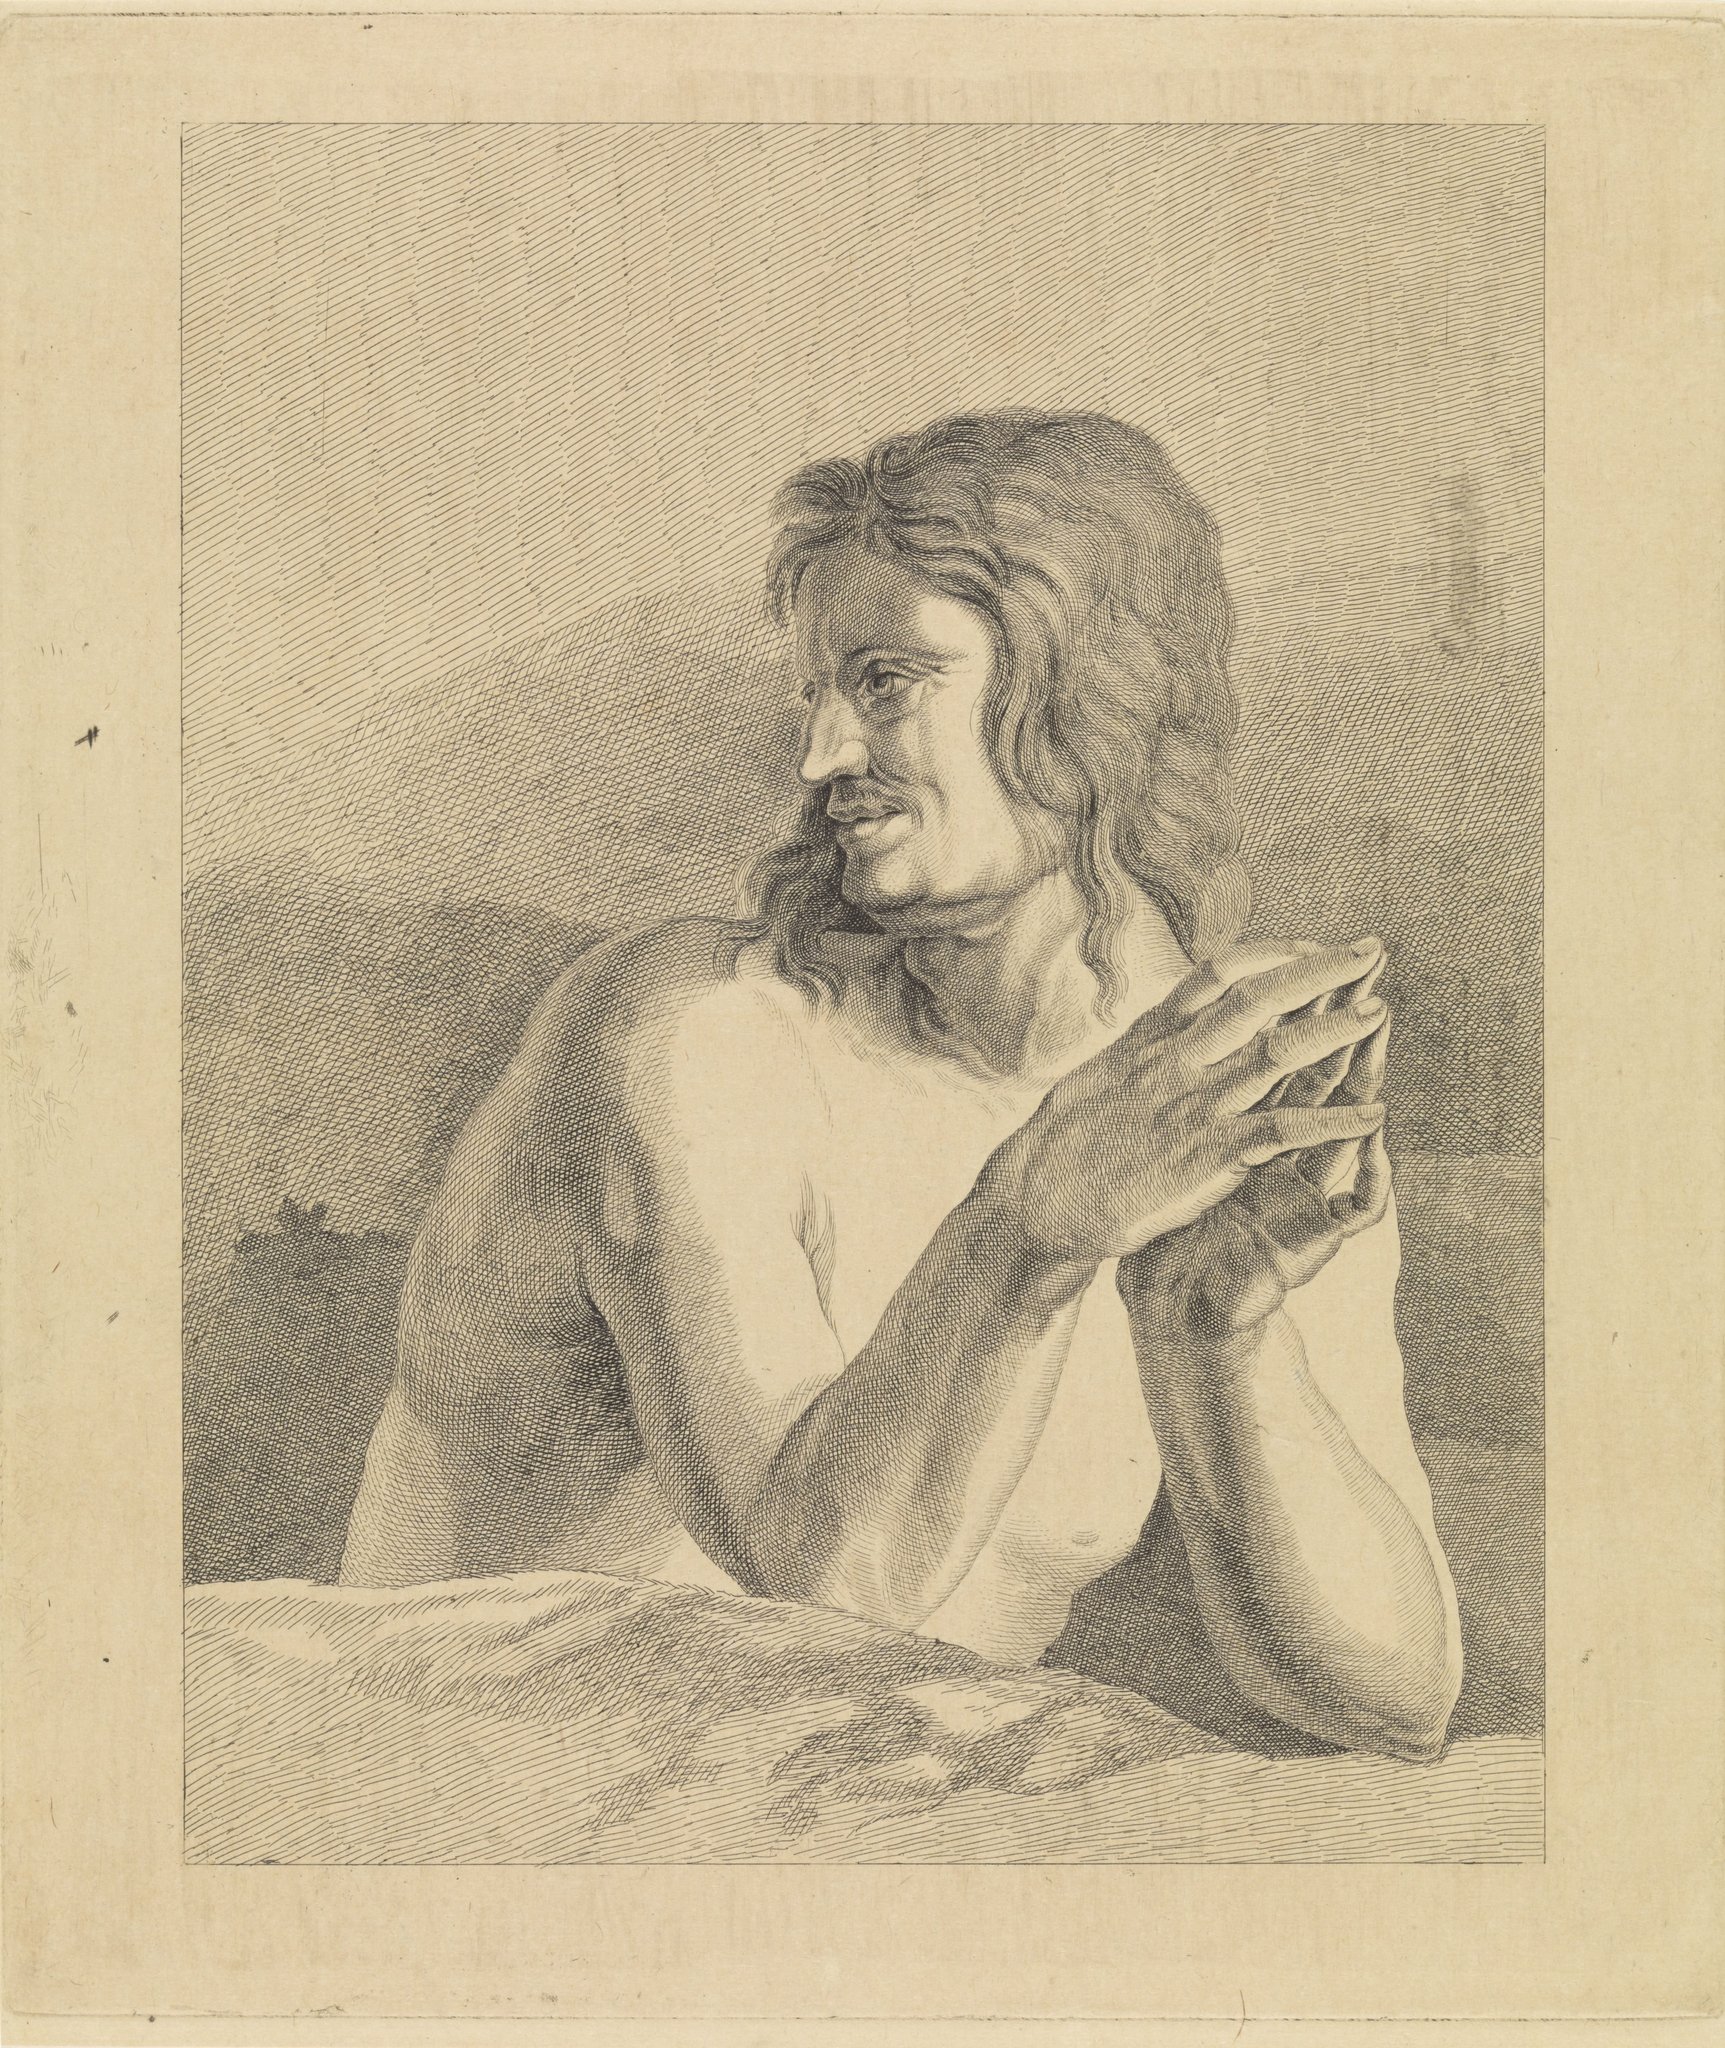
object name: print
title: Figuur uit het Laatste Oordeel van Lucas van Leyden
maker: pieter de mare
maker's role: print maker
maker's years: 1758-1796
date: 1768-1796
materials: paper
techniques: engraving, etching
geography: leiden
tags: hands folded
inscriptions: collector's mark: Lugt 240